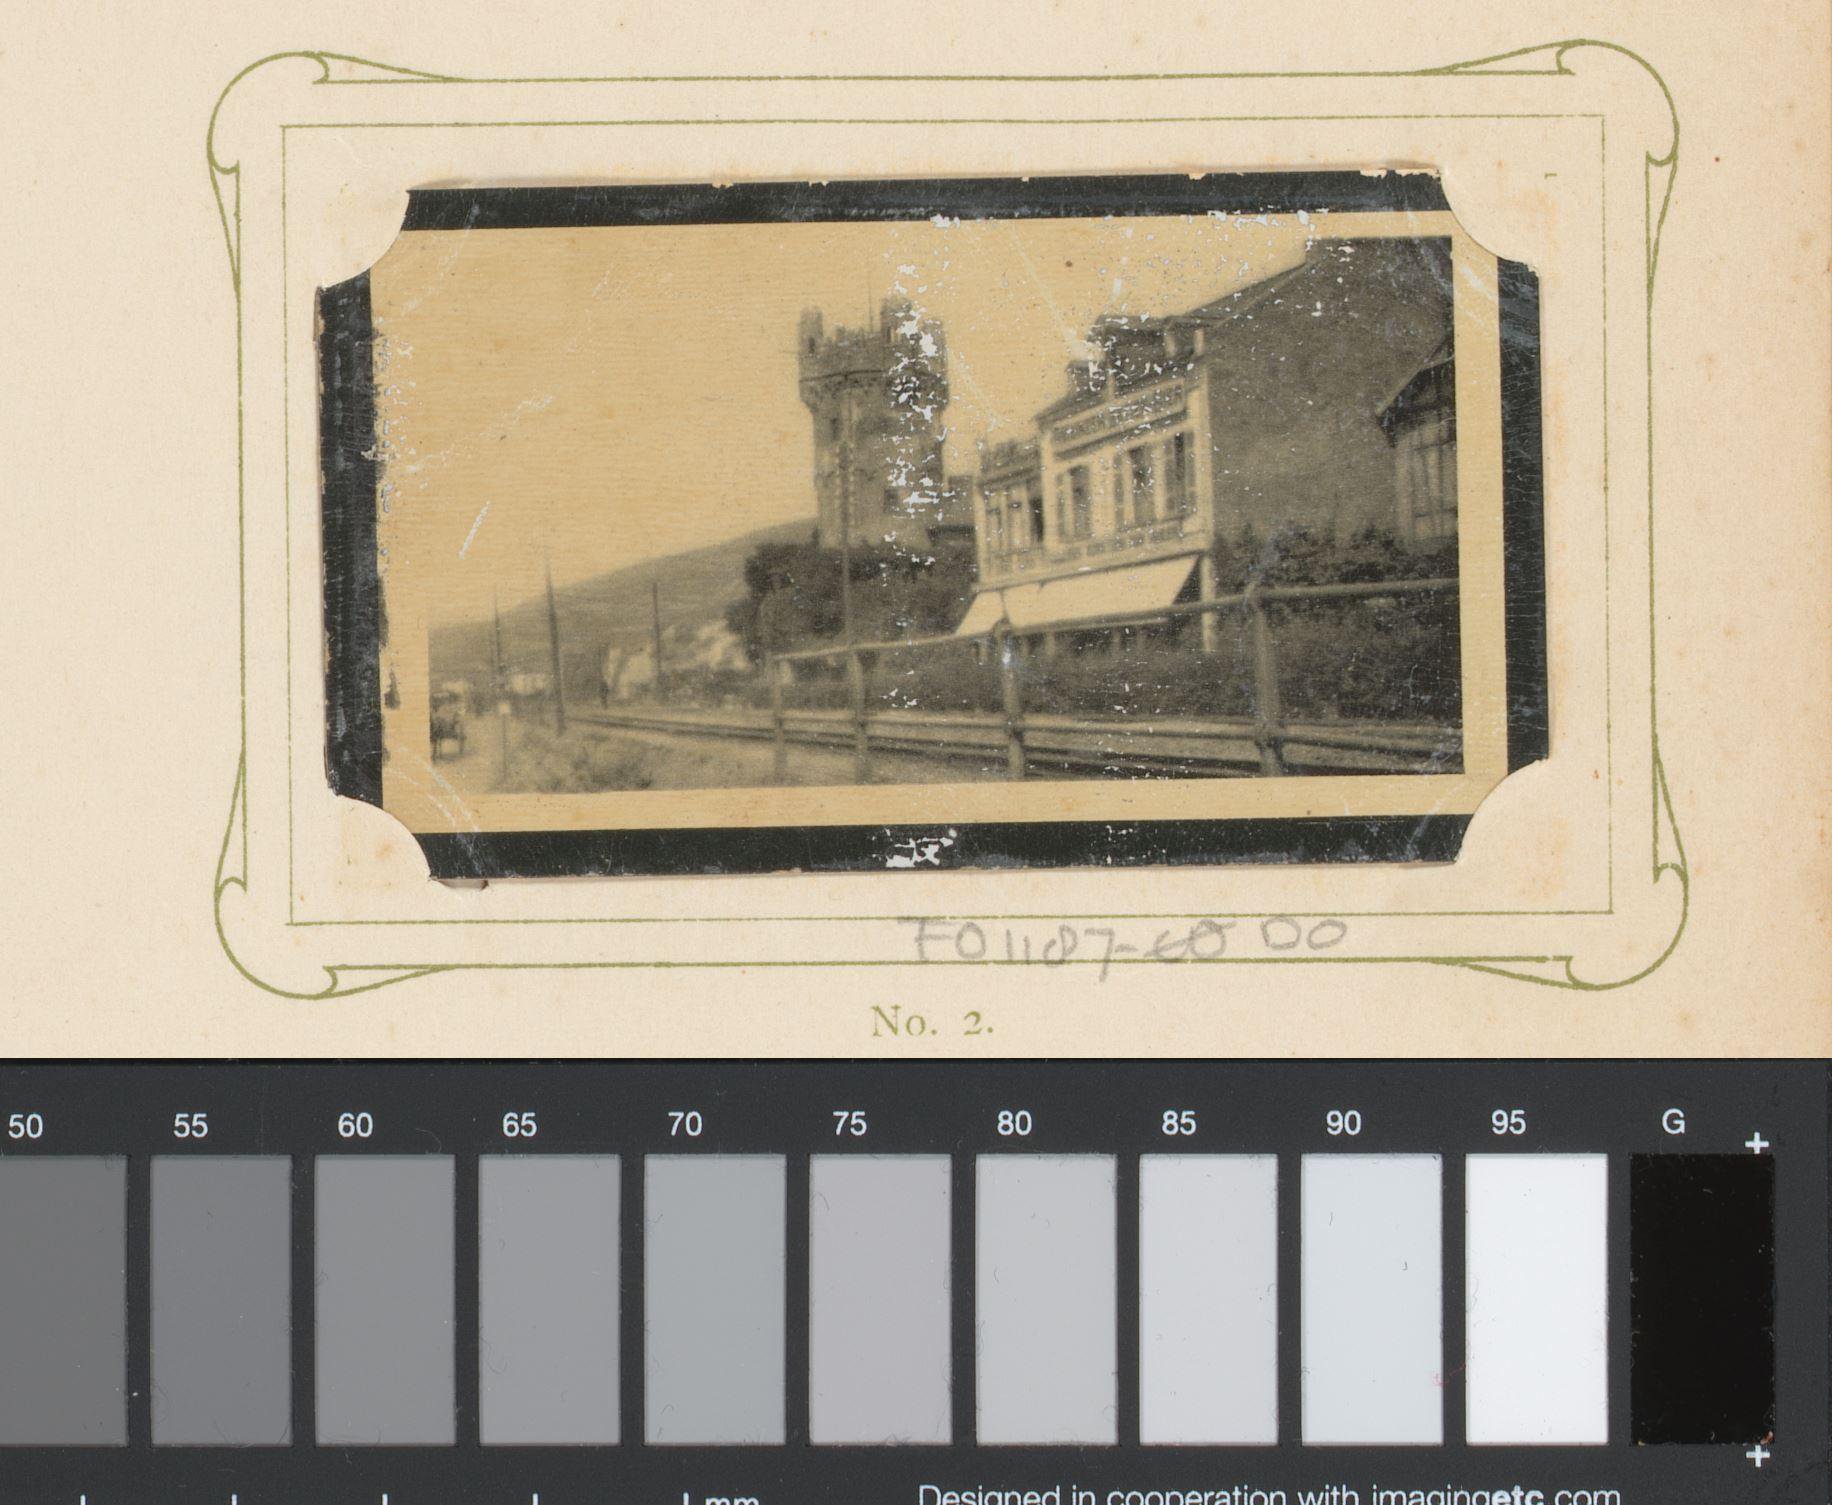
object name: photomechanical print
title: Gezicht op Rüdesheim, Duitsland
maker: Anonymous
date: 1905-1906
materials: paper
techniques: photograph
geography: rüdesheim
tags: prospect of village, silhouette of village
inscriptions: inscription: ‘No. 2./ Rüdesheim.’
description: Deze prent maakt deel uit van een album.